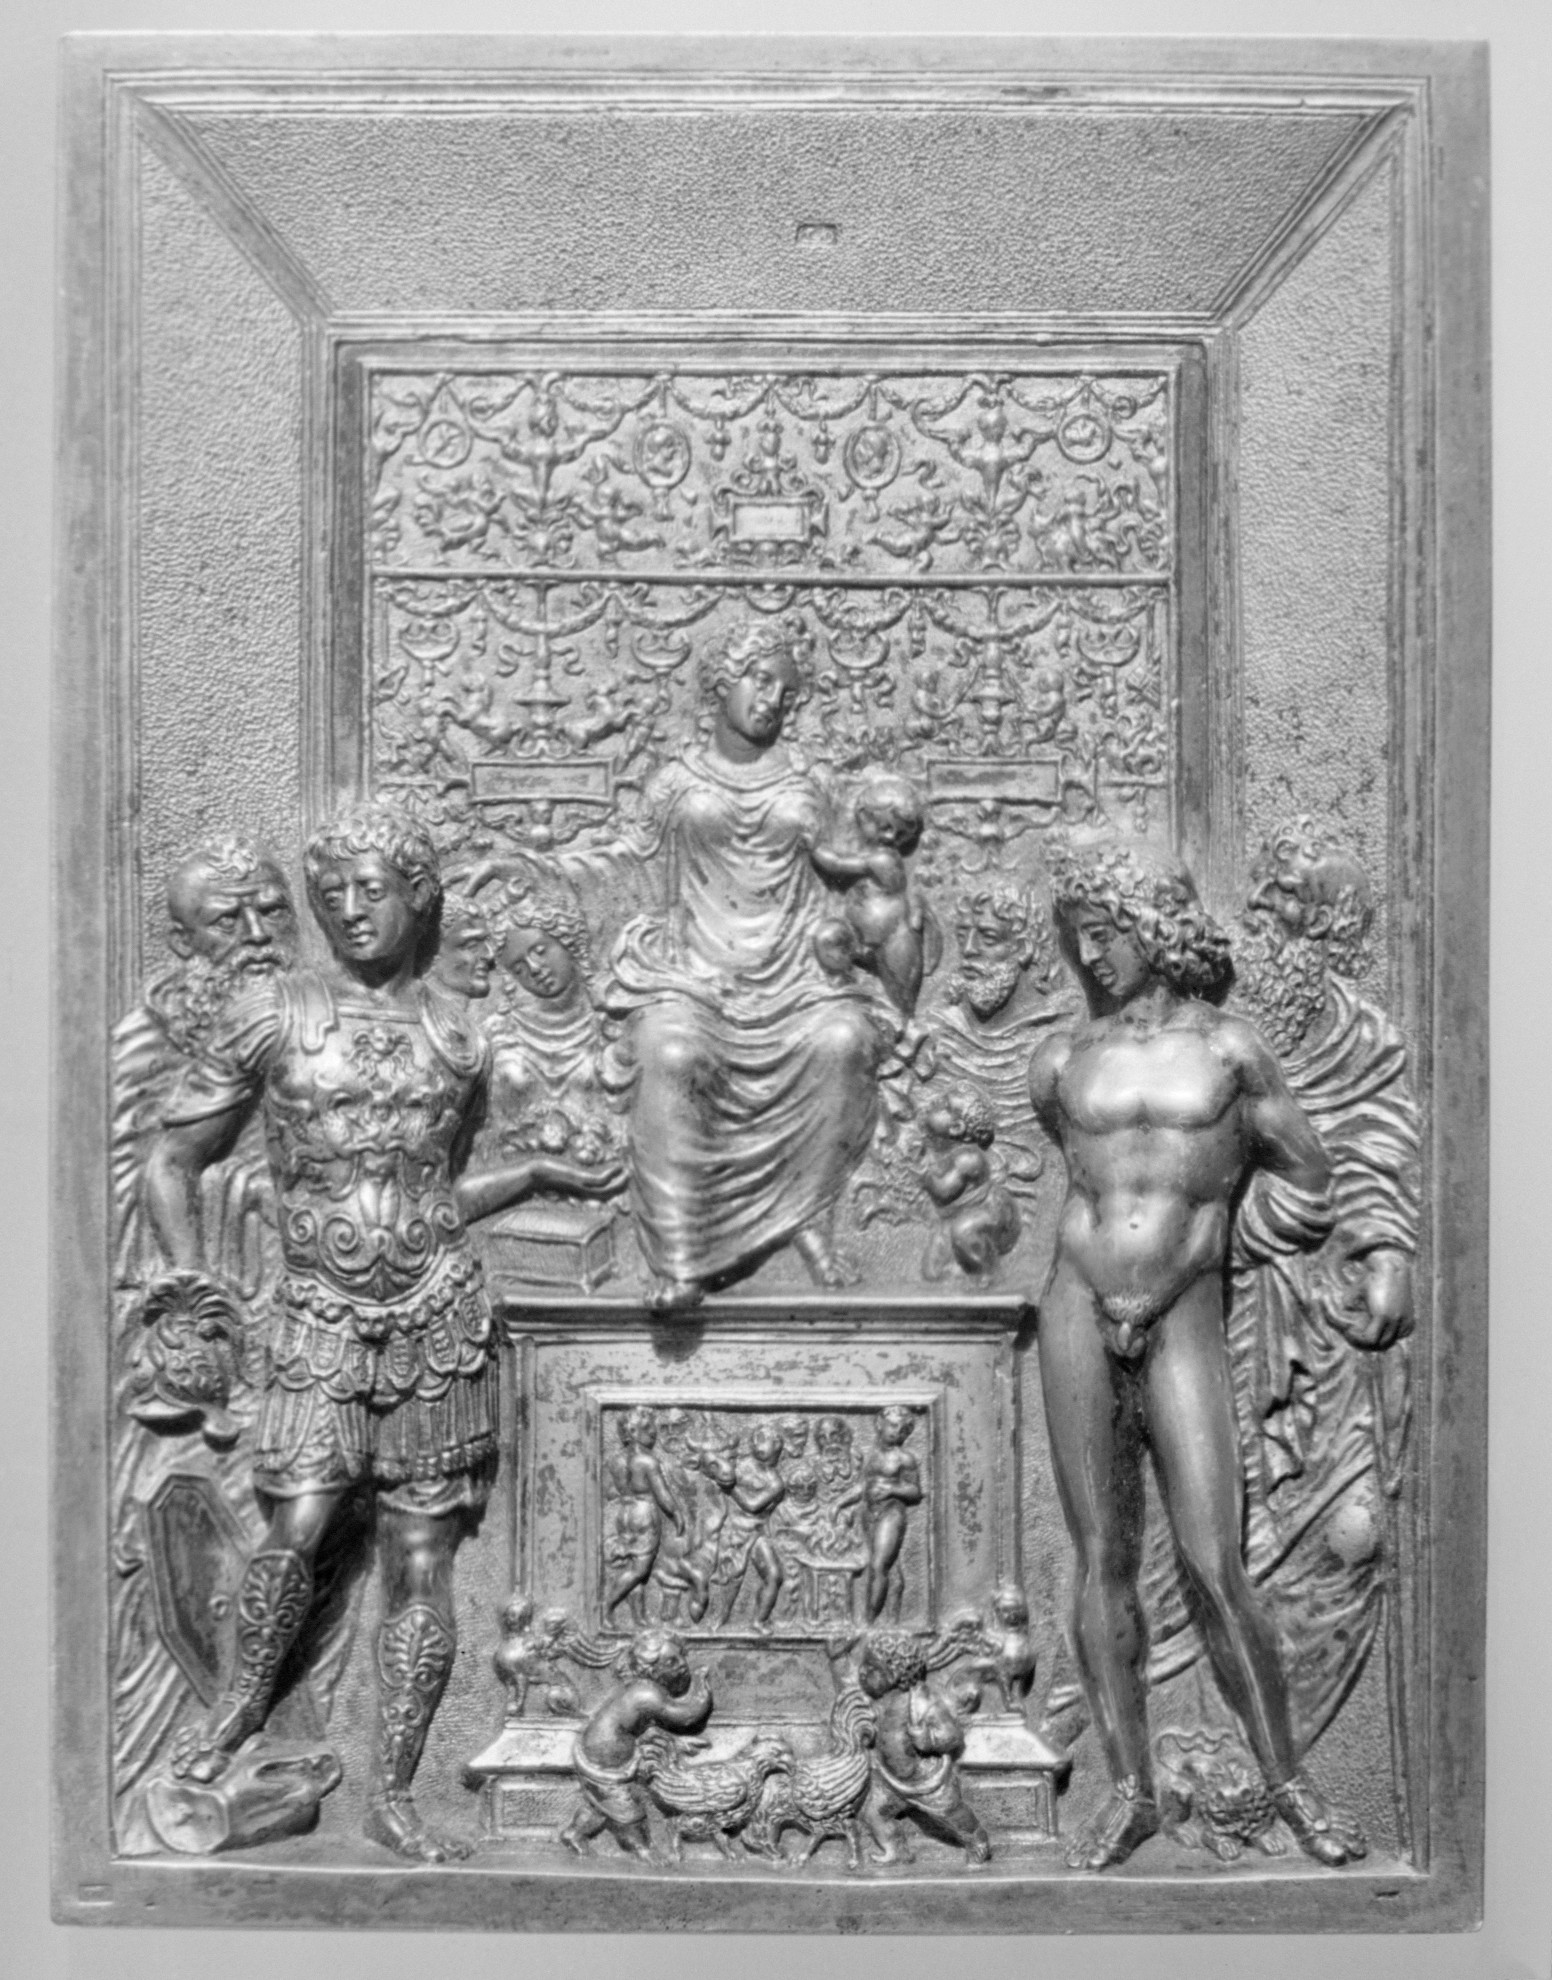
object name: plaquette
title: Madonna and Child enthroned with Saints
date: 1801-1900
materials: gilt, silver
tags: male nudes,madonna and child,saints